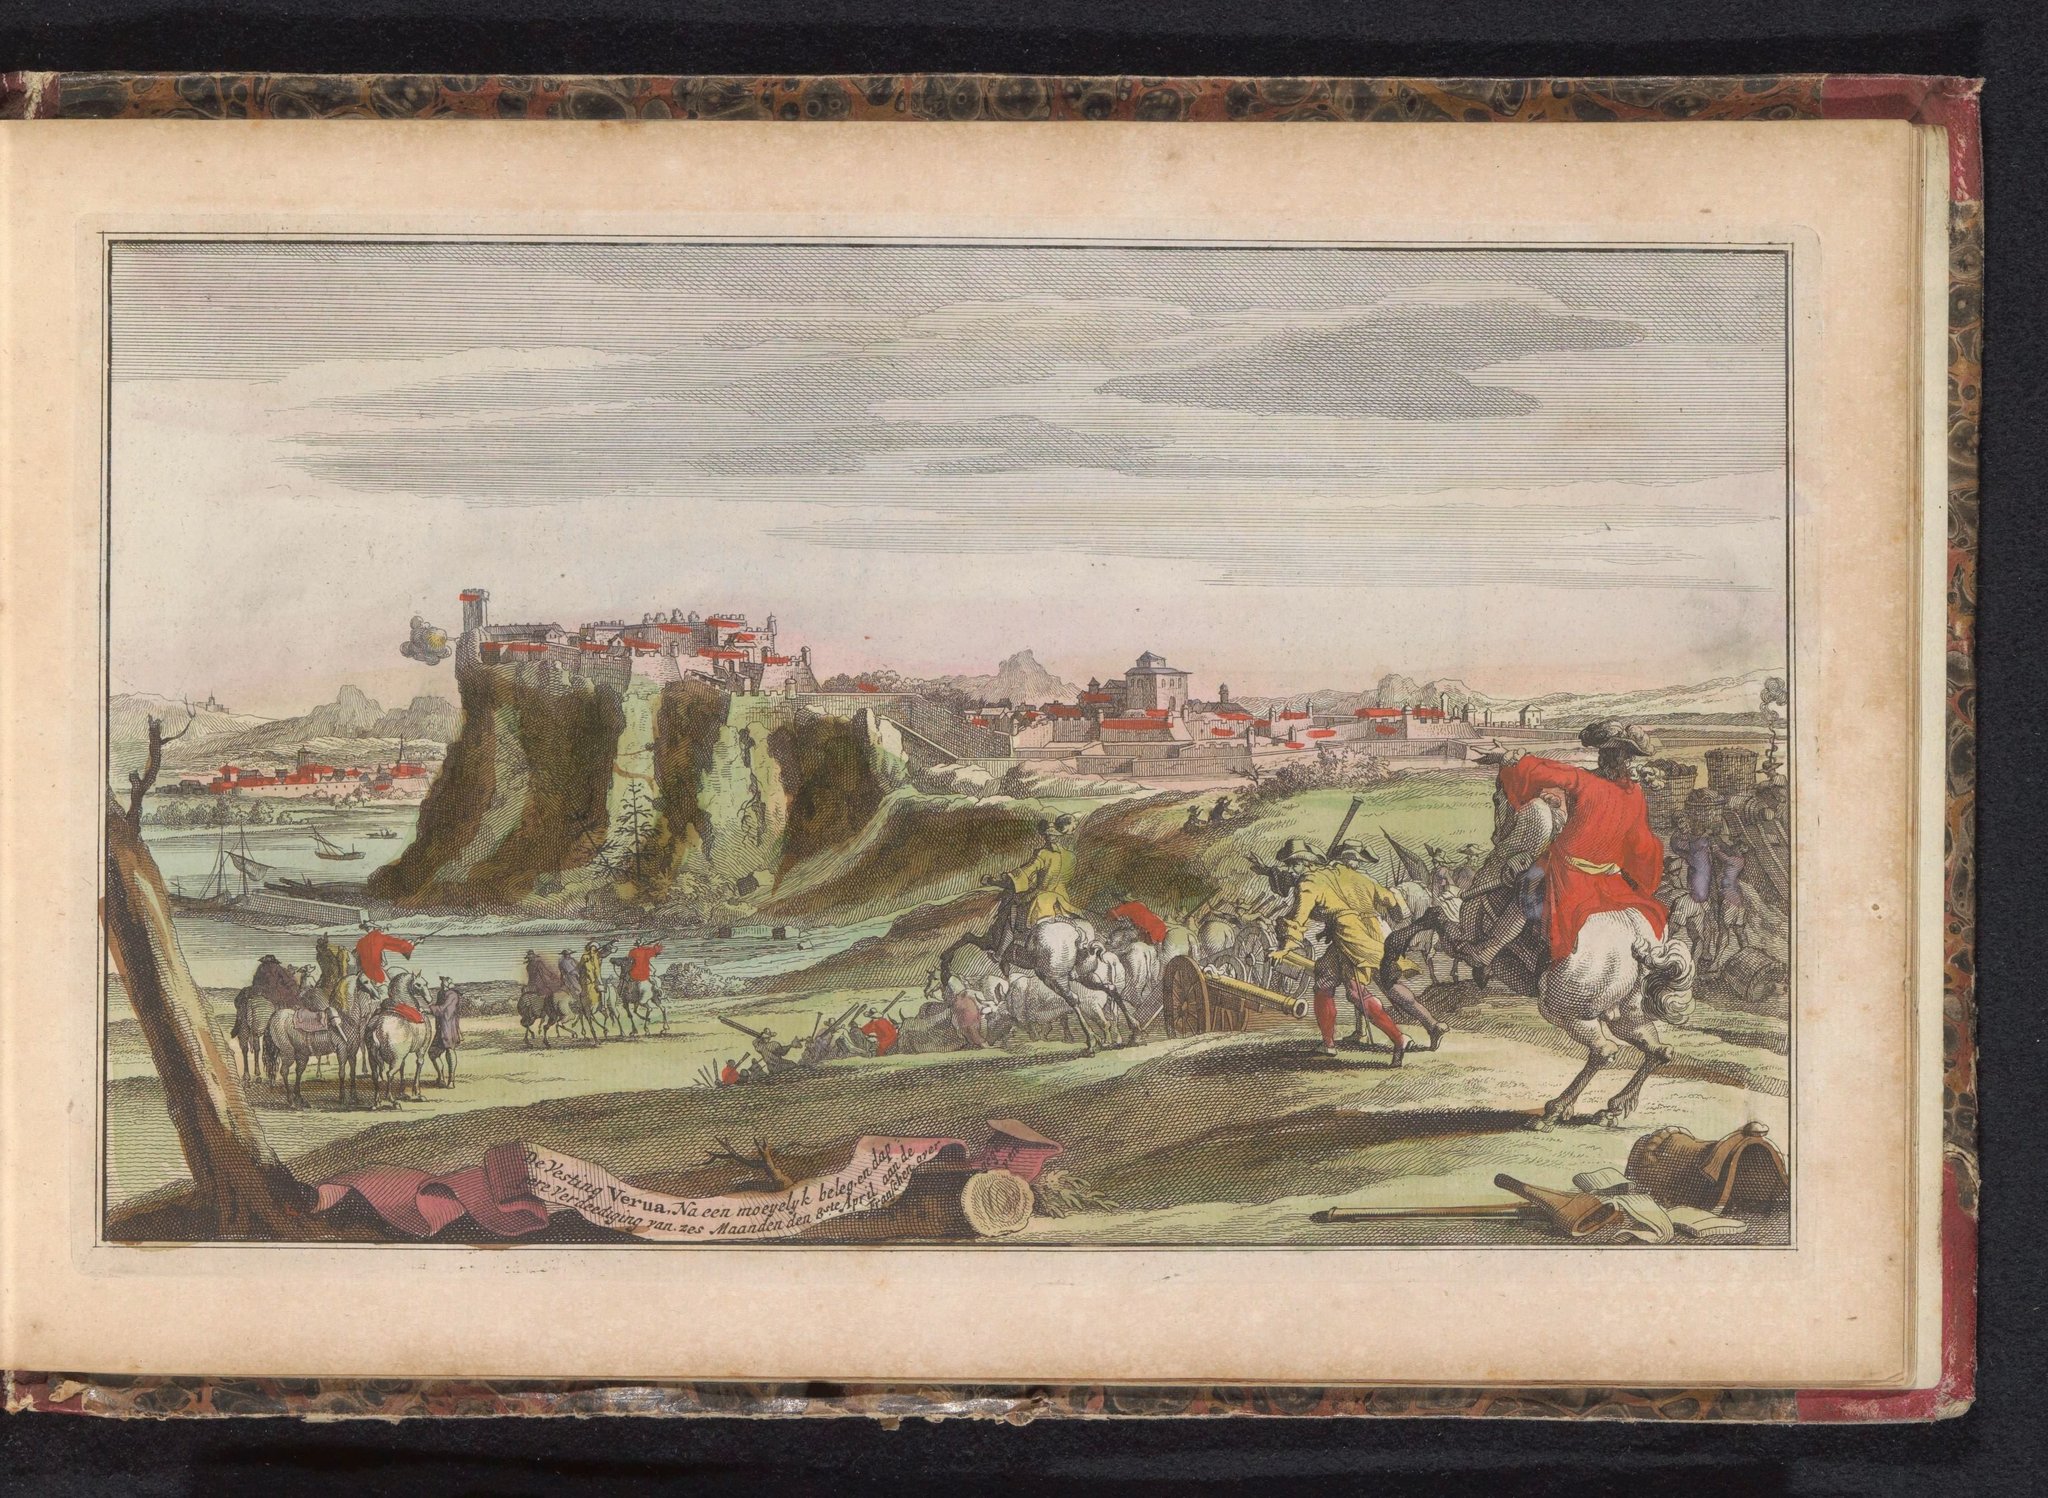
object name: print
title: Beleg van Verua, ca. 1702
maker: Anonymous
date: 1735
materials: paper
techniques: engraving, etching, hand coloring, lacquer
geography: northern netherlands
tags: capture of city (after the siege)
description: Gezicht op de stad Verua (Verue) aan de Po in Piemonte, belegerd en veroverd door de Fransen, ca. 1702. Op de voorgrond de oprukkende Franse troepen. Onderdeel van een atlas met 223 kaarten van landen en steden en oorlogstaferelen in Europa in de periode ca. 1690-1735.